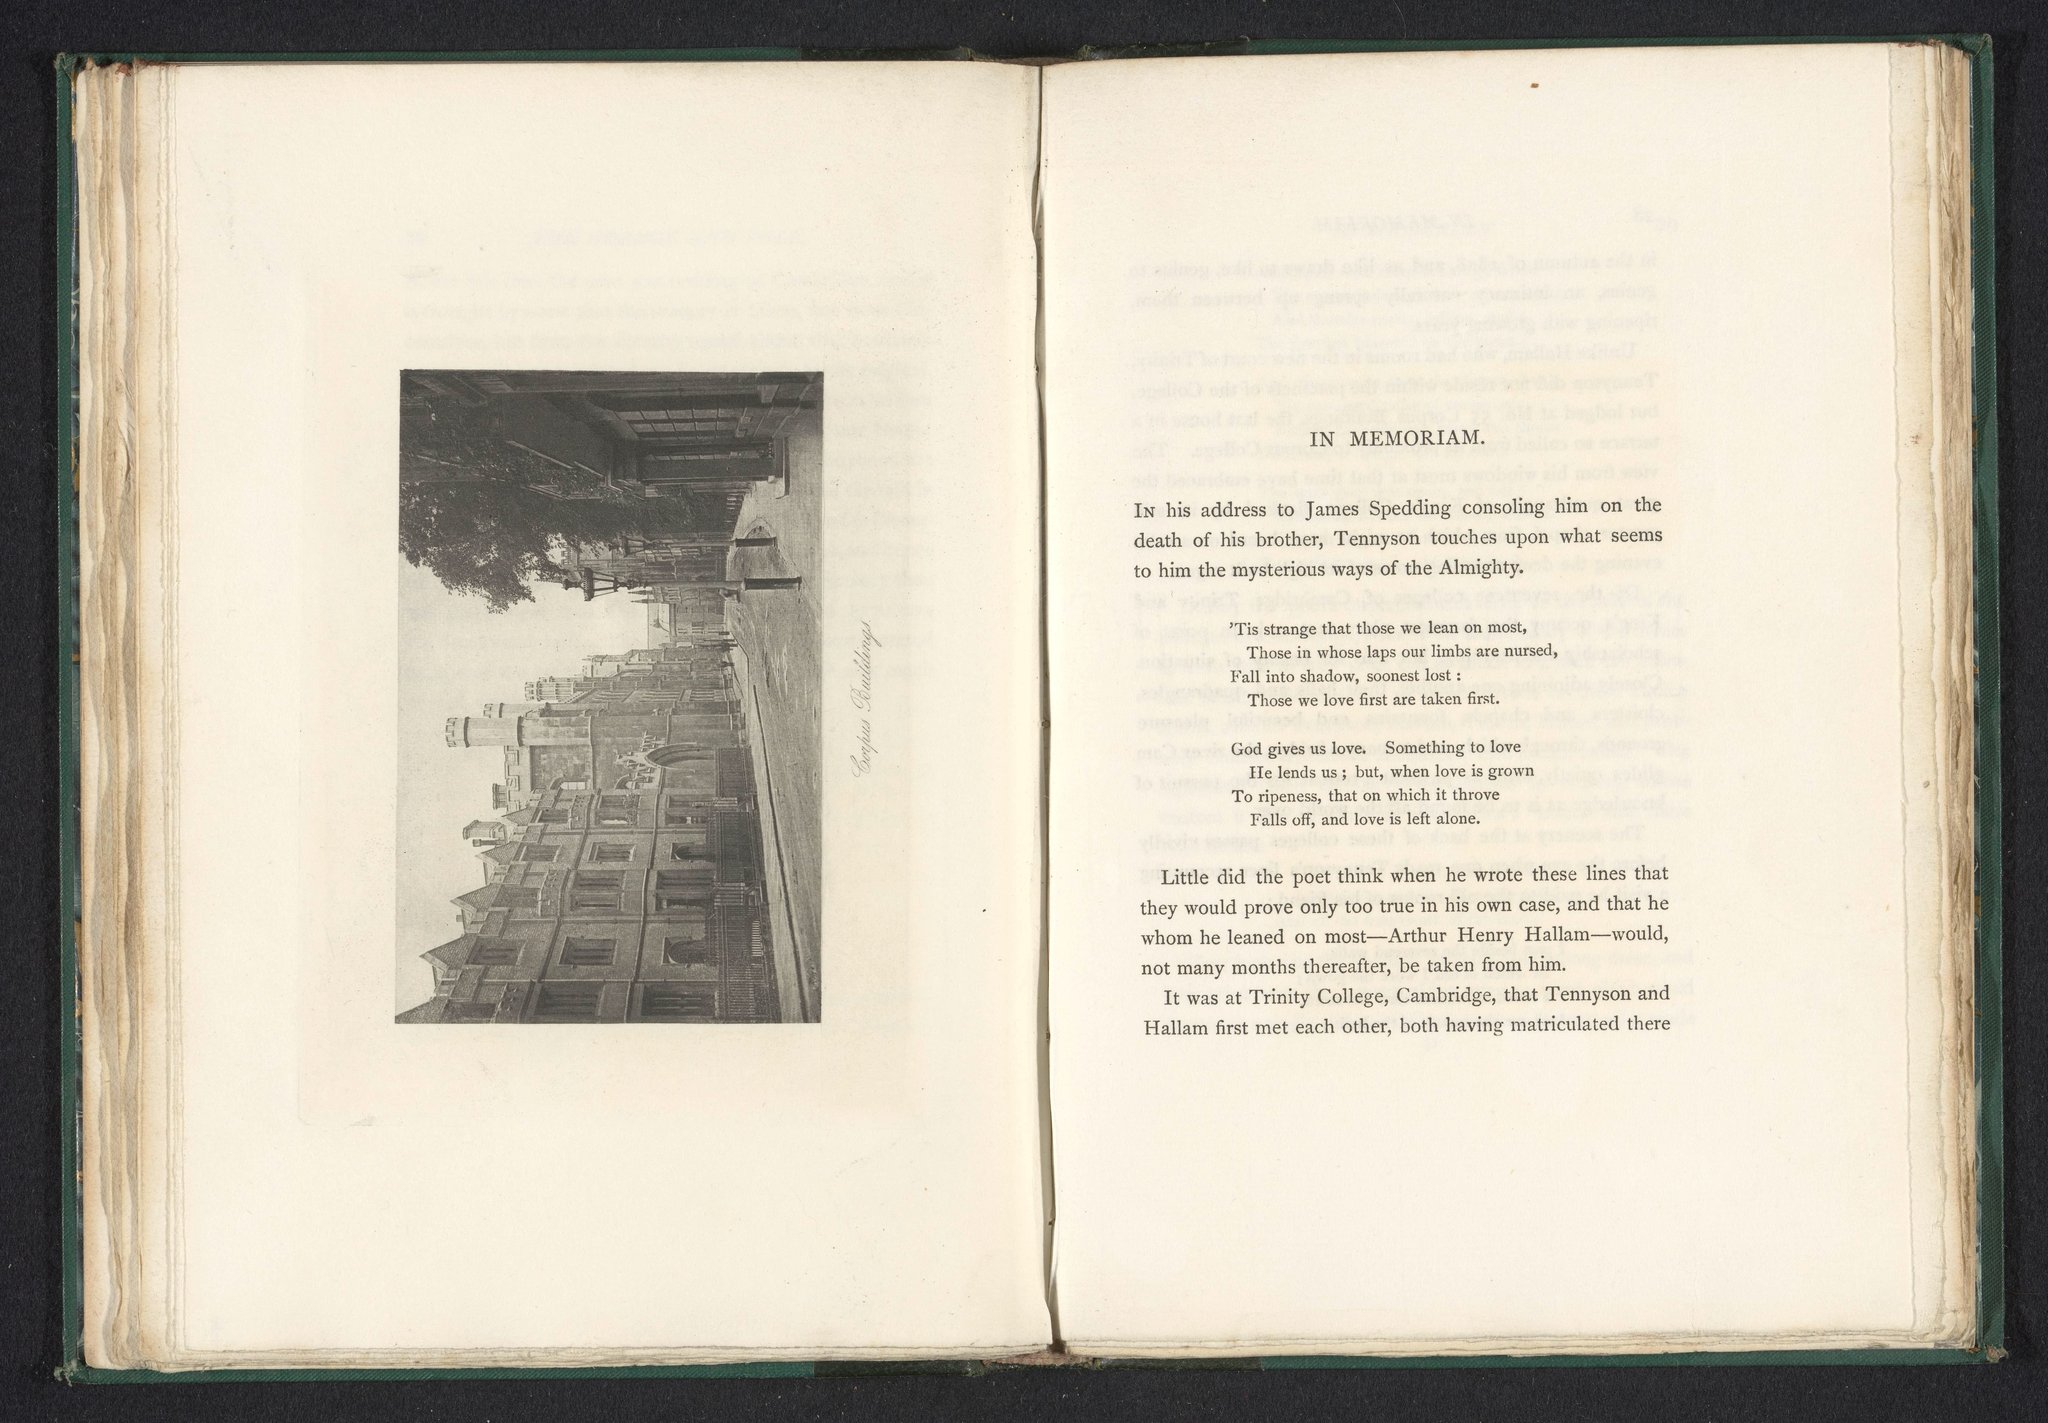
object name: page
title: Corpus buildings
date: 1884-1889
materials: paper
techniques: photoaquatint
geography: glasgow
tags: university building, college, façade (of house or building), street